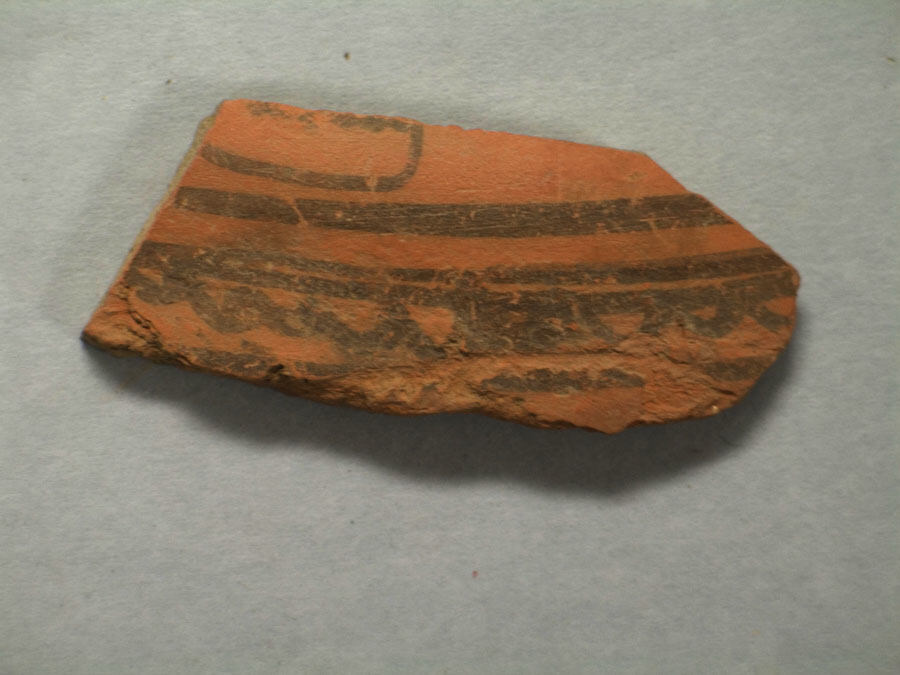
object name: shard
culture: pakistani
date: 301-500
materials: terracotta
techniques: painting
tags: gandhara